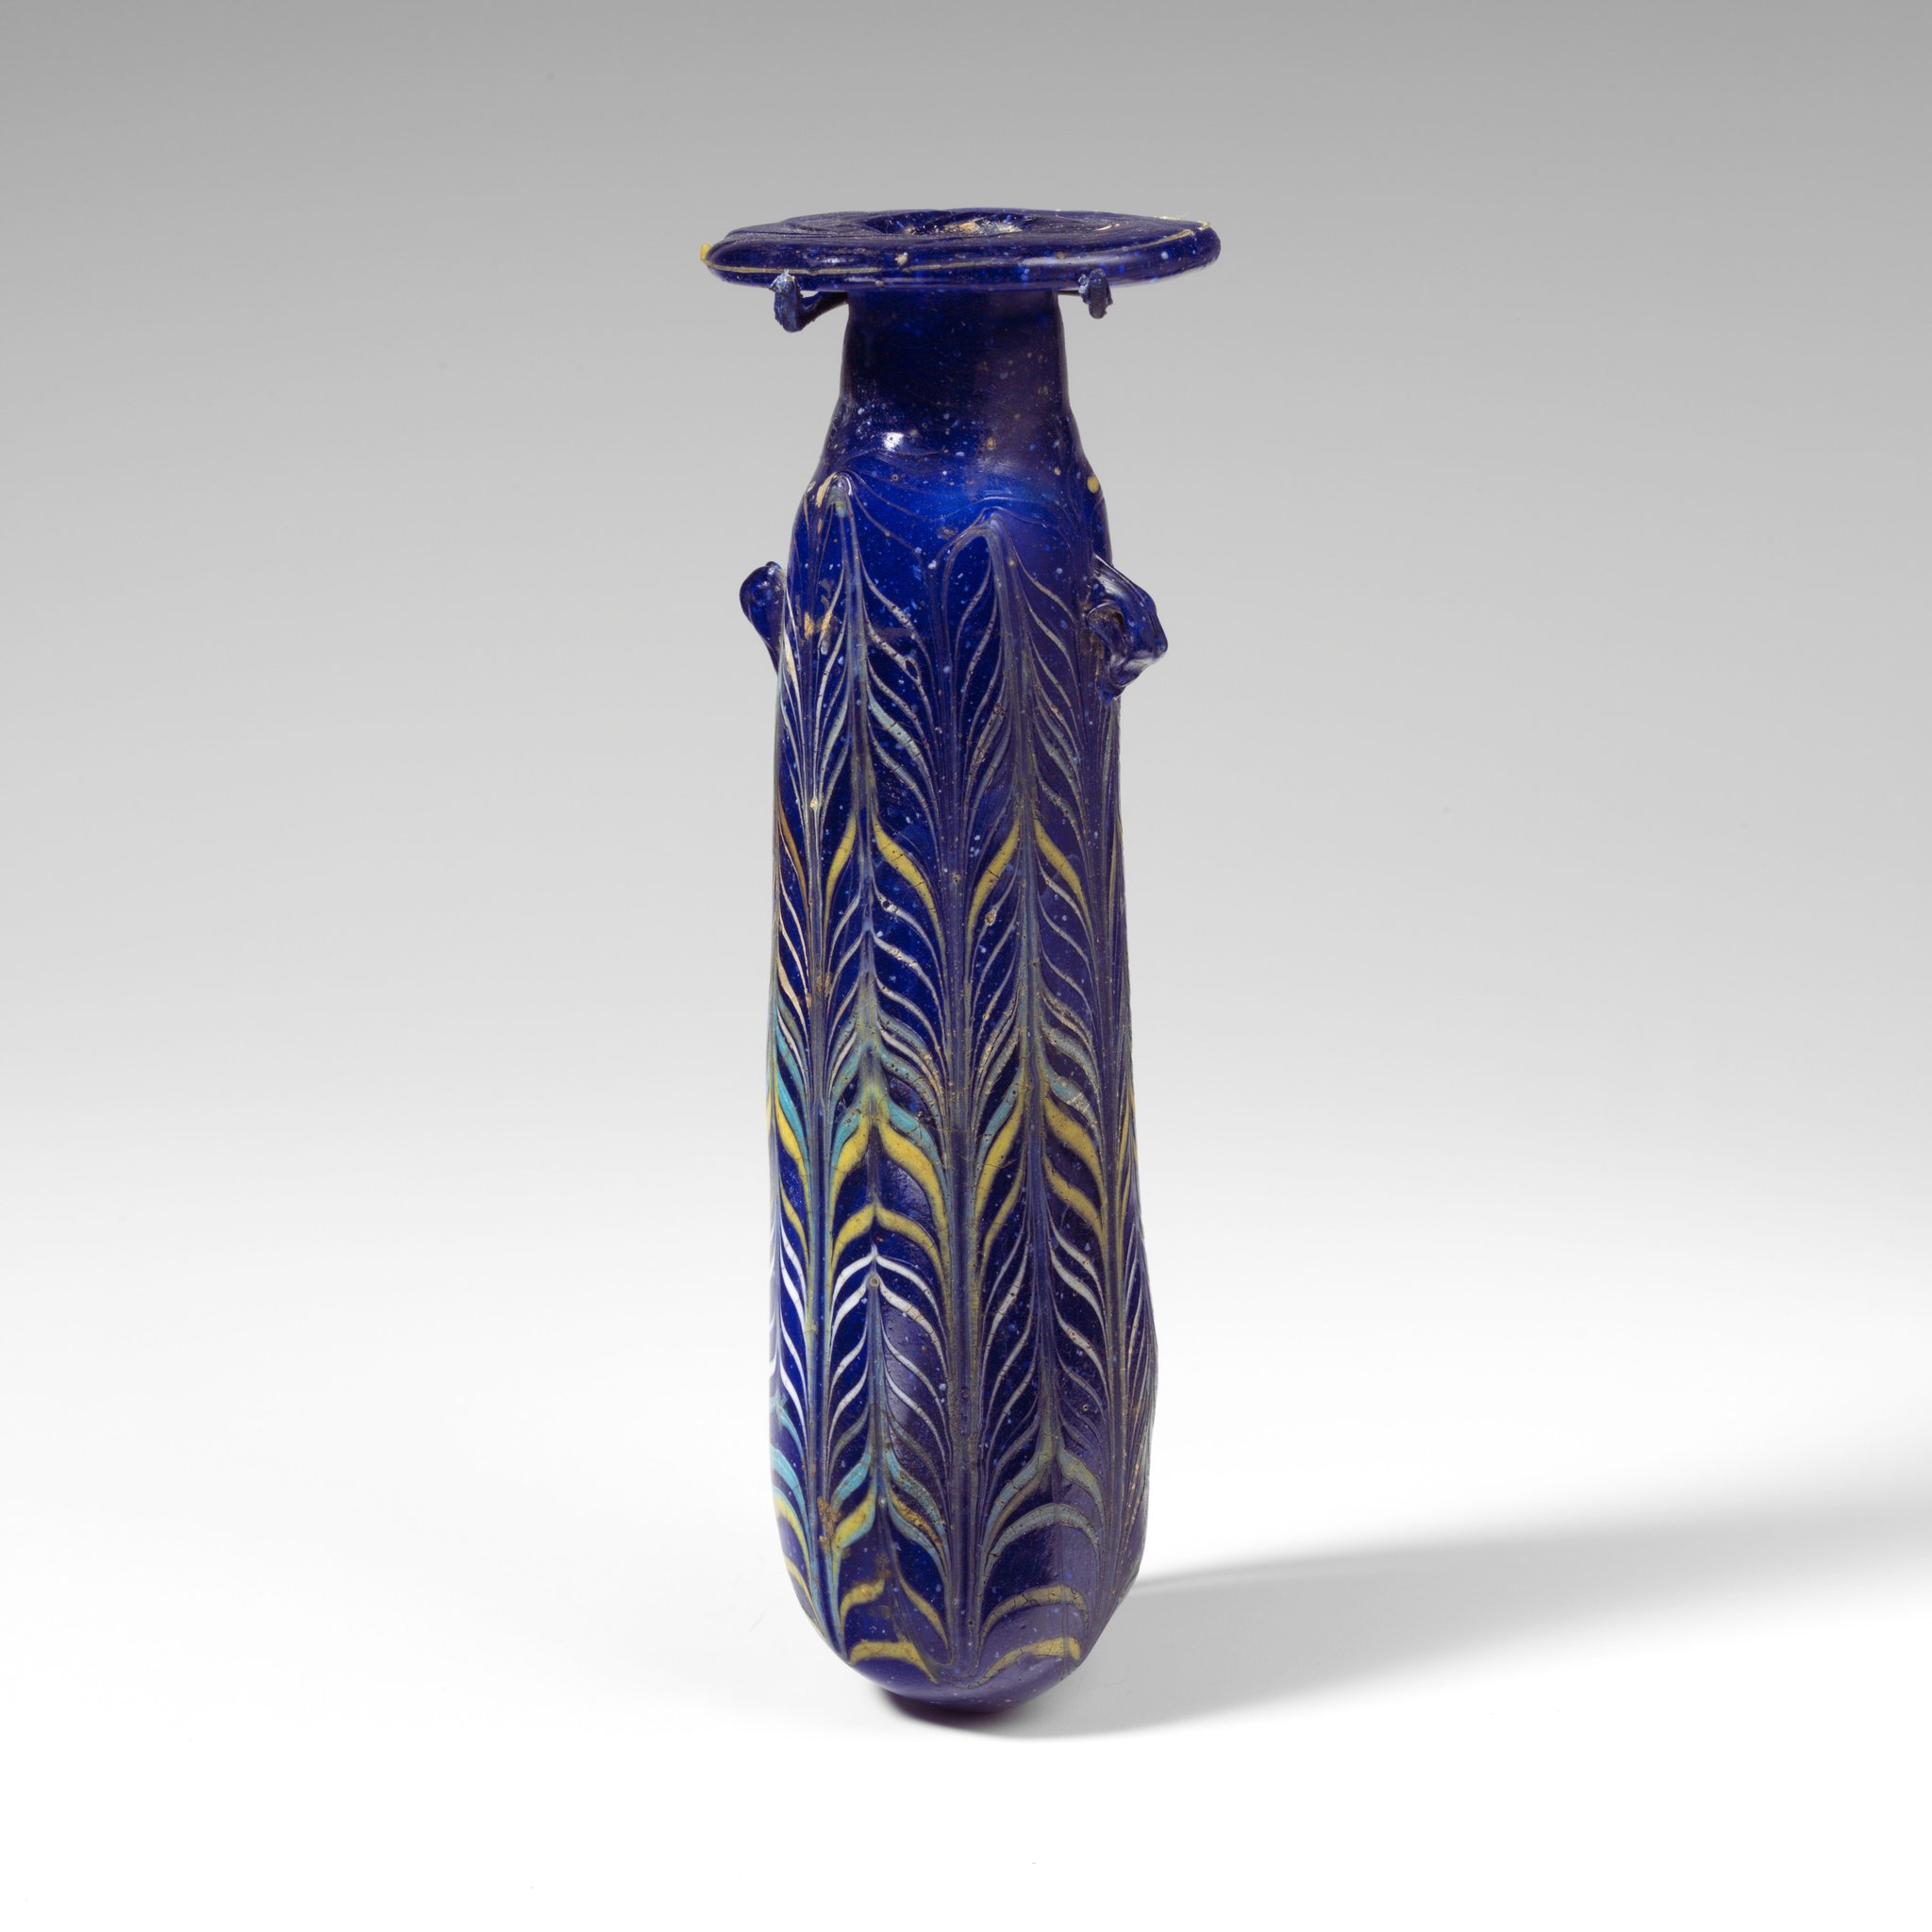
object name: alabastron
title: Glass alabastron (perfume bottle)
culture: eastern mediterranean or south italian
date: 334-268 BCE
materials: glass